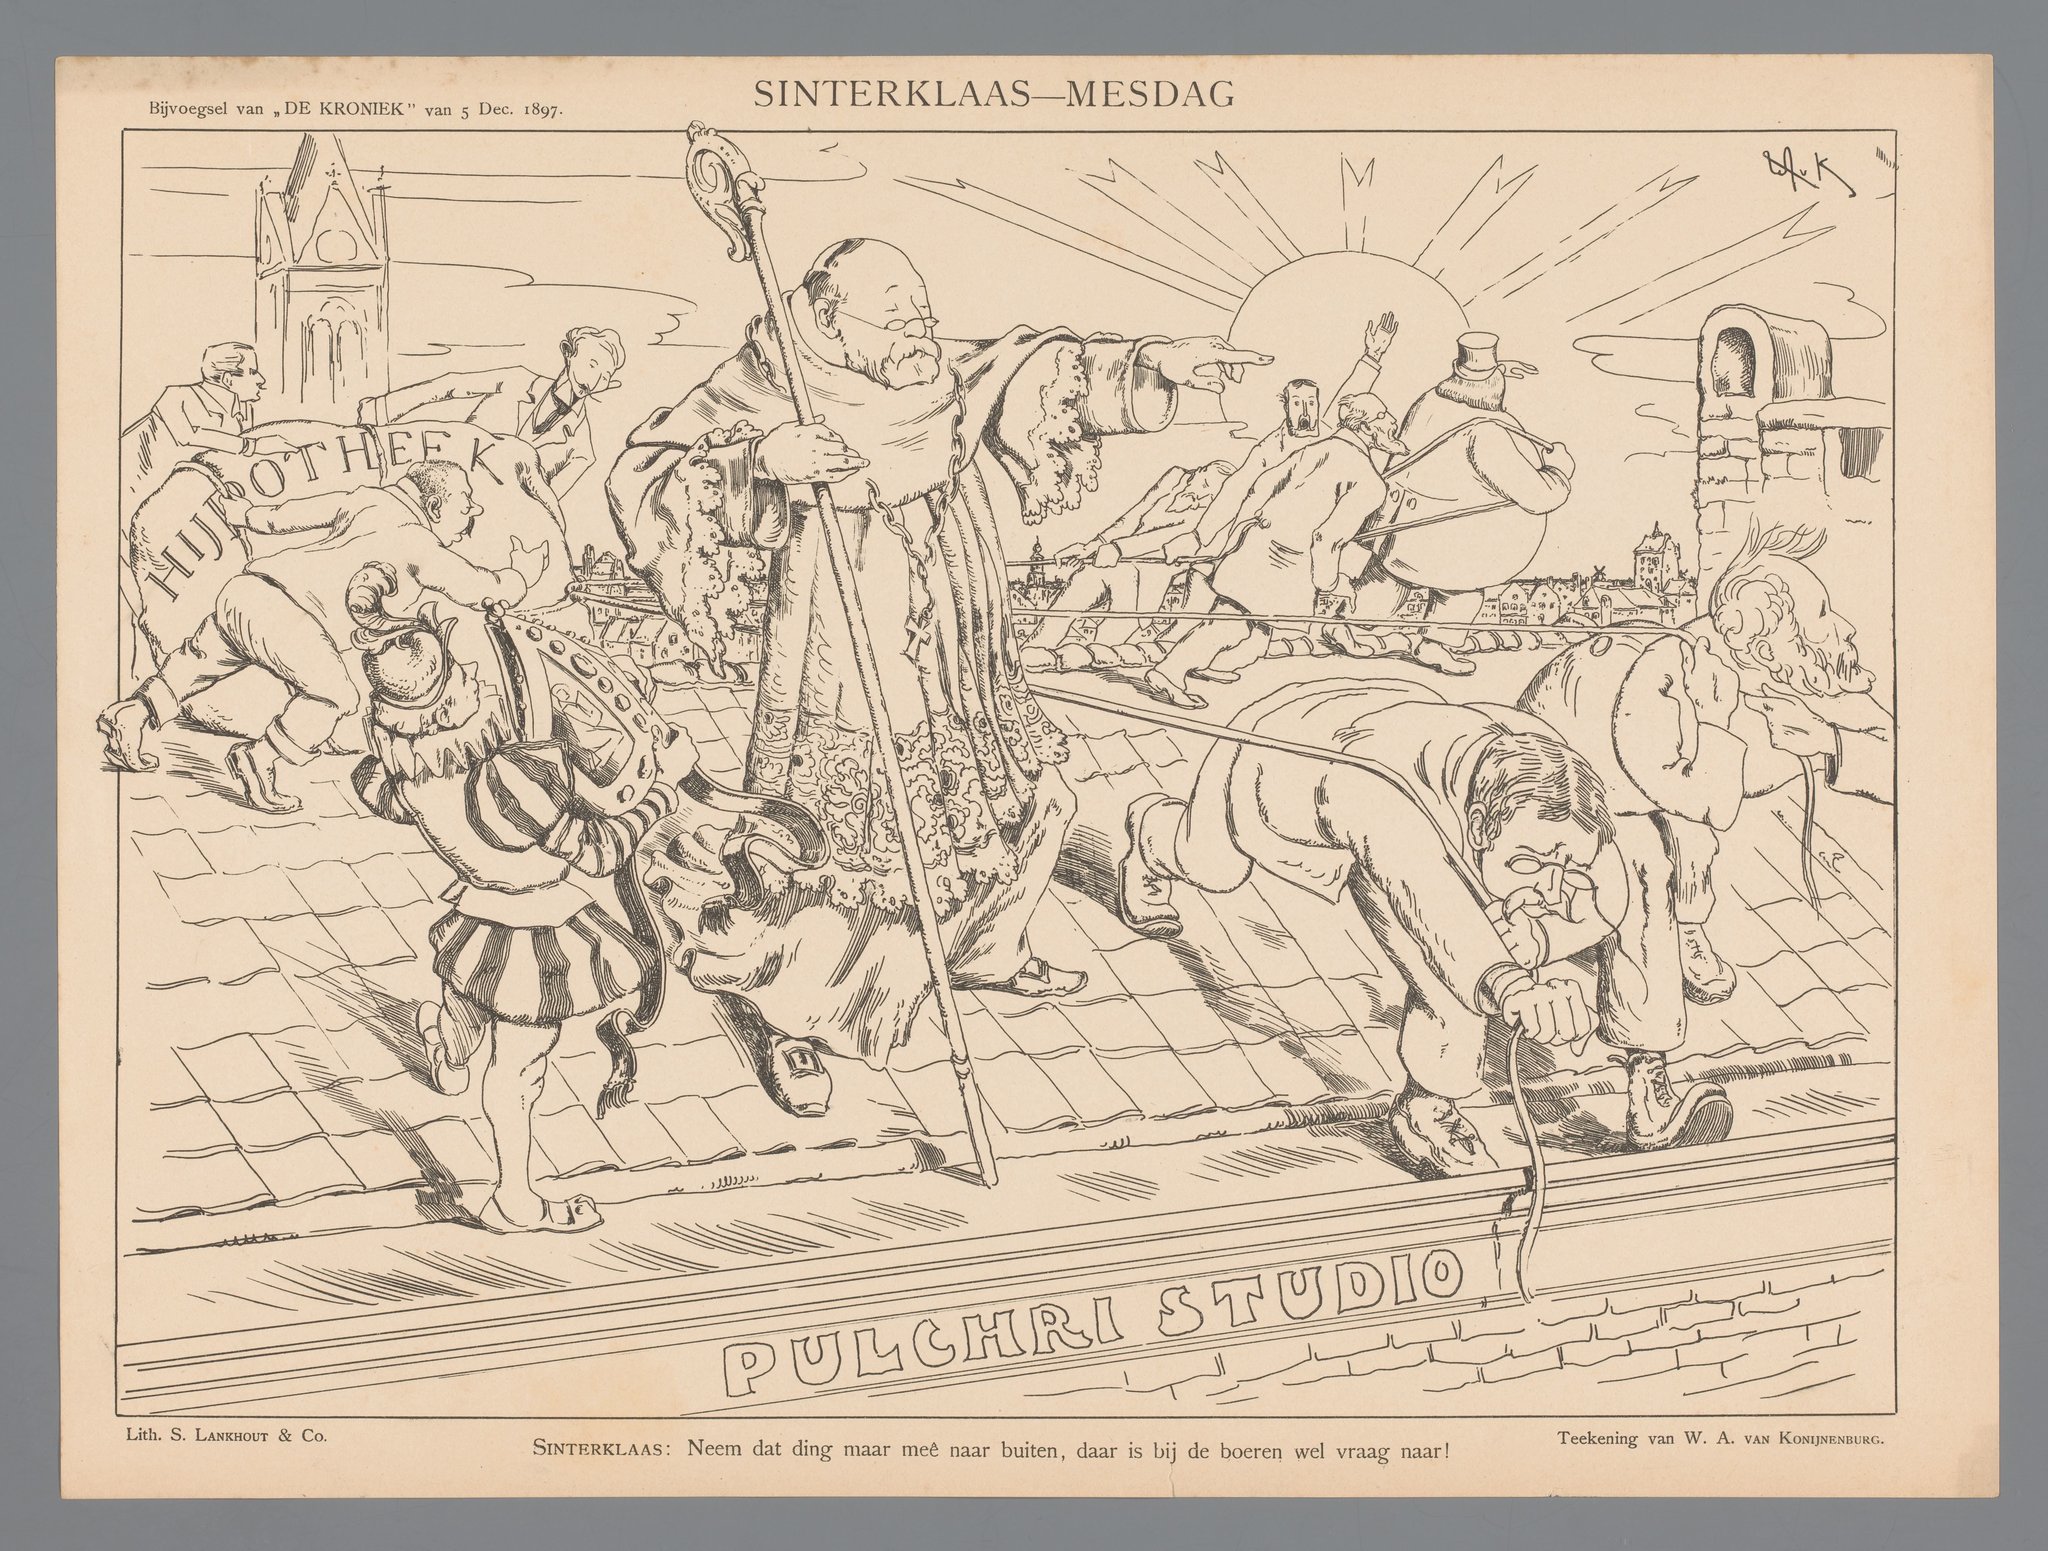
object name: print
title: Sinterklaas-Mesdagh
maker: willem van konijnenburg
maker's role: draughtsman, painter, print maker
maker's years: 1868-1943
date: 1897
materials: paper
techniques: lithograph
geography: the hague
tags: the hague, painter, print maker, draughtsman, hendrik willem mesdag, festivities on st. nicholas (eve) (december 5)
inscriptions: date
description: Prent uit het bijvoegsel van: De Kroniek 3 (1897), 5 december 1897.